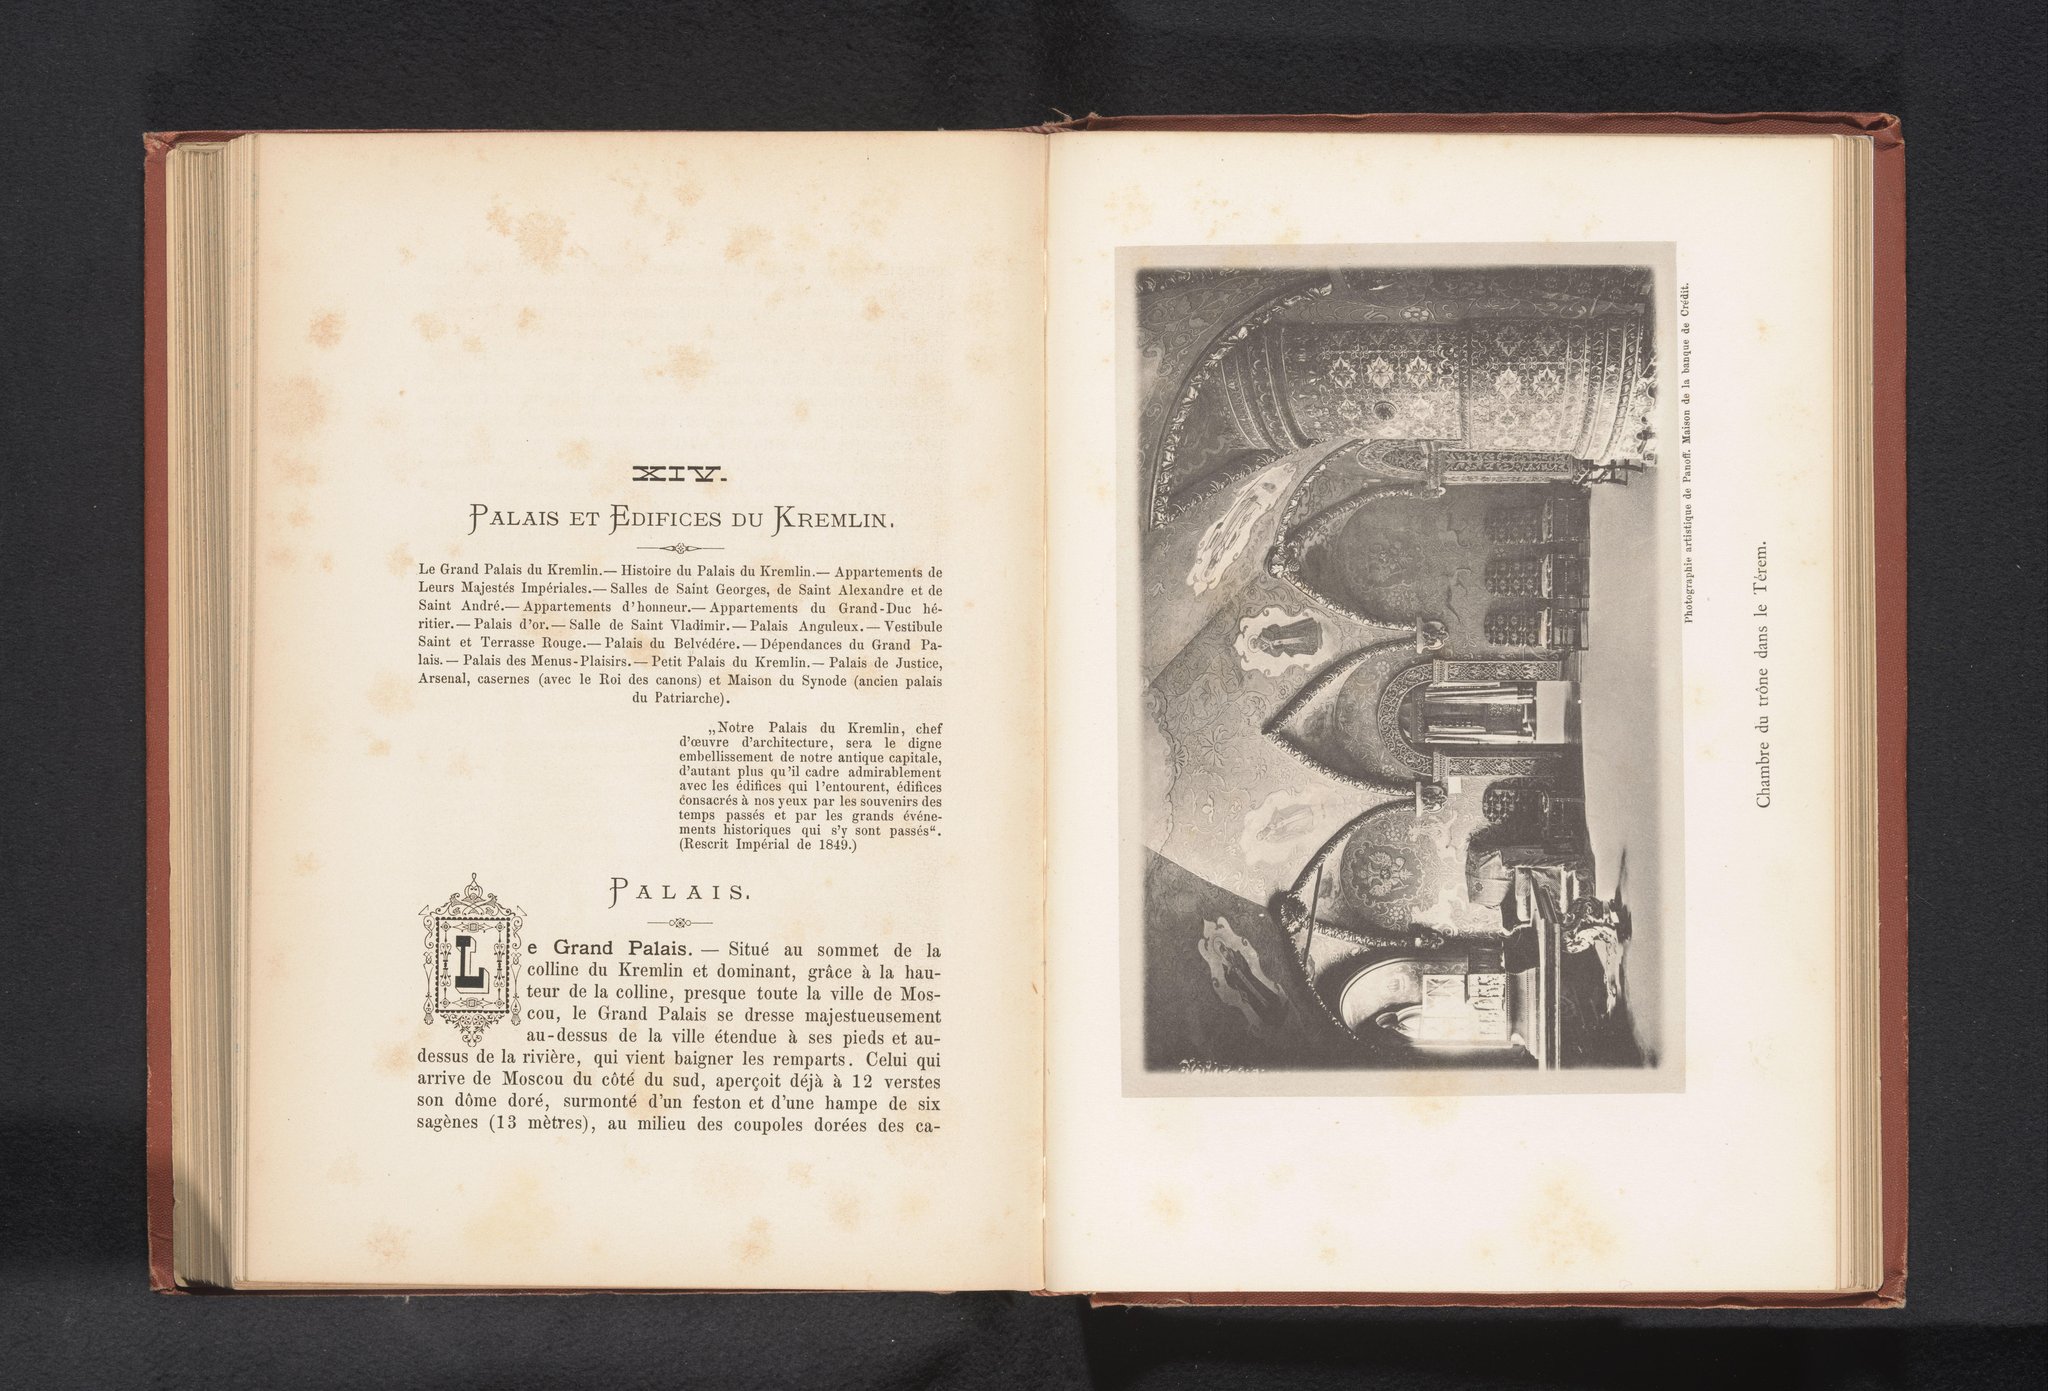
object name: page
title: Interieur van de troonzaal in het Terempaleis in het Kremlin van Moskou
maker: Anonymous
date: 1873-1883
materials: paper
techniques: photograph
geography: kremlin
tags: palace, throne-room, wall-covering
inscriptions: name: ‘Photographie artistique de Panoff. Maison de la banque de Crédit.’